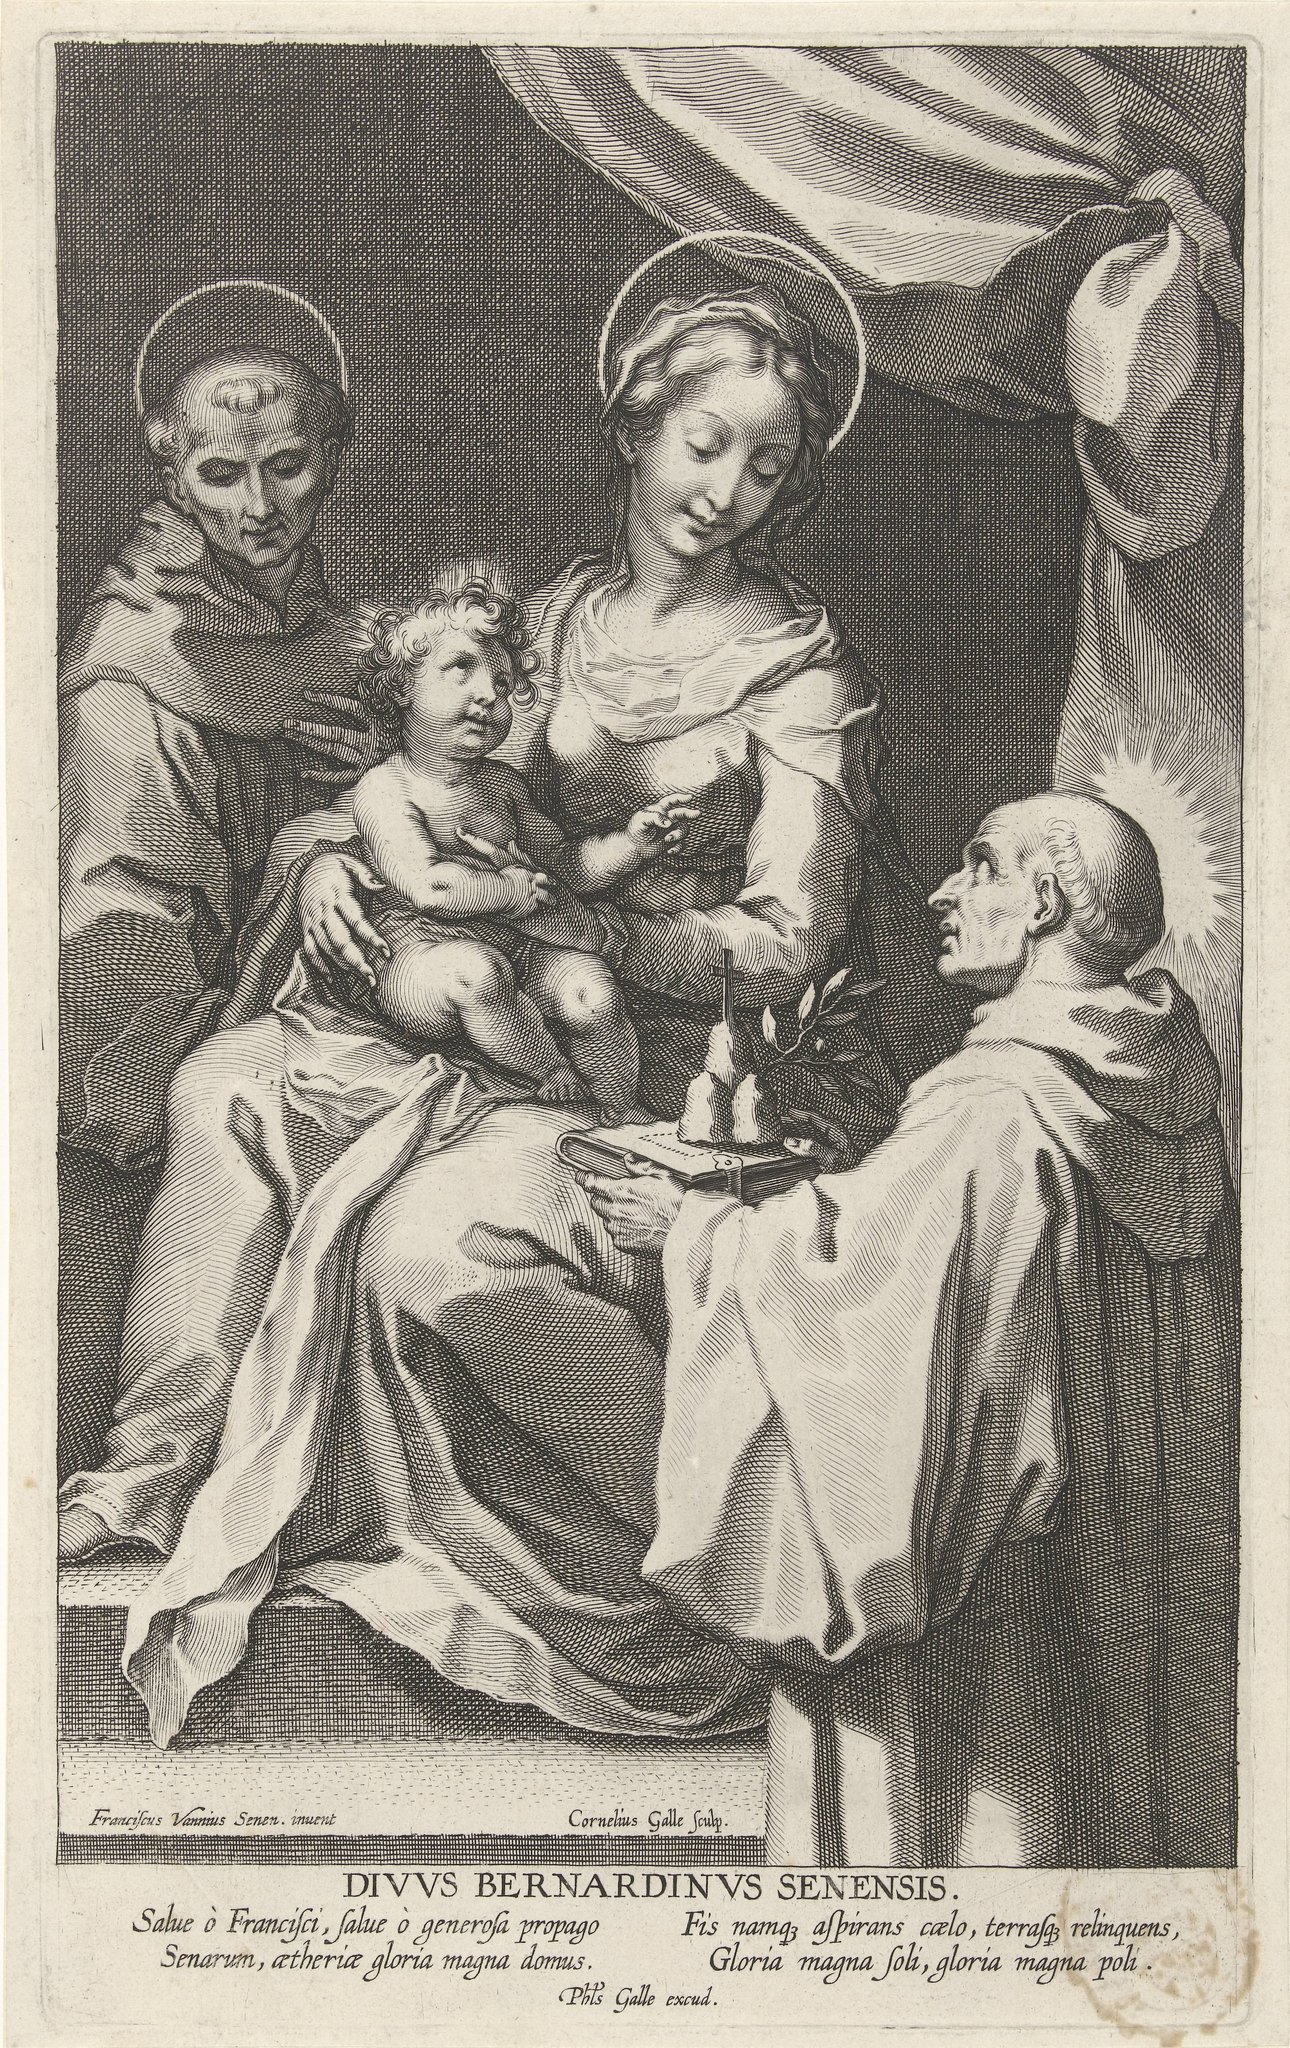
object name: print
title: Maria met Kind en de H. Bernardinus van Siena en H. Gerardus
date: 1586-1612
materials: paper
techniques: engraving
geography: southern netherlands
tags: madonna accompanied by saint(s), saints, bernardino of siena, franciscan friar; possible attributes: book, tablet (disk) with ihs monogram, three mitres at his feet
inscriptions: collector's mark: Lugt 240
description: Tronende Maria met het Kind op haar schoot. De heilige Bernardinus van Siena biedt haar een boek aan met daarop een Calvarieberg met kruis en olijftak. Achter haar staat de heilige Gerardus. Onder de voorstelling een Latijns vers.